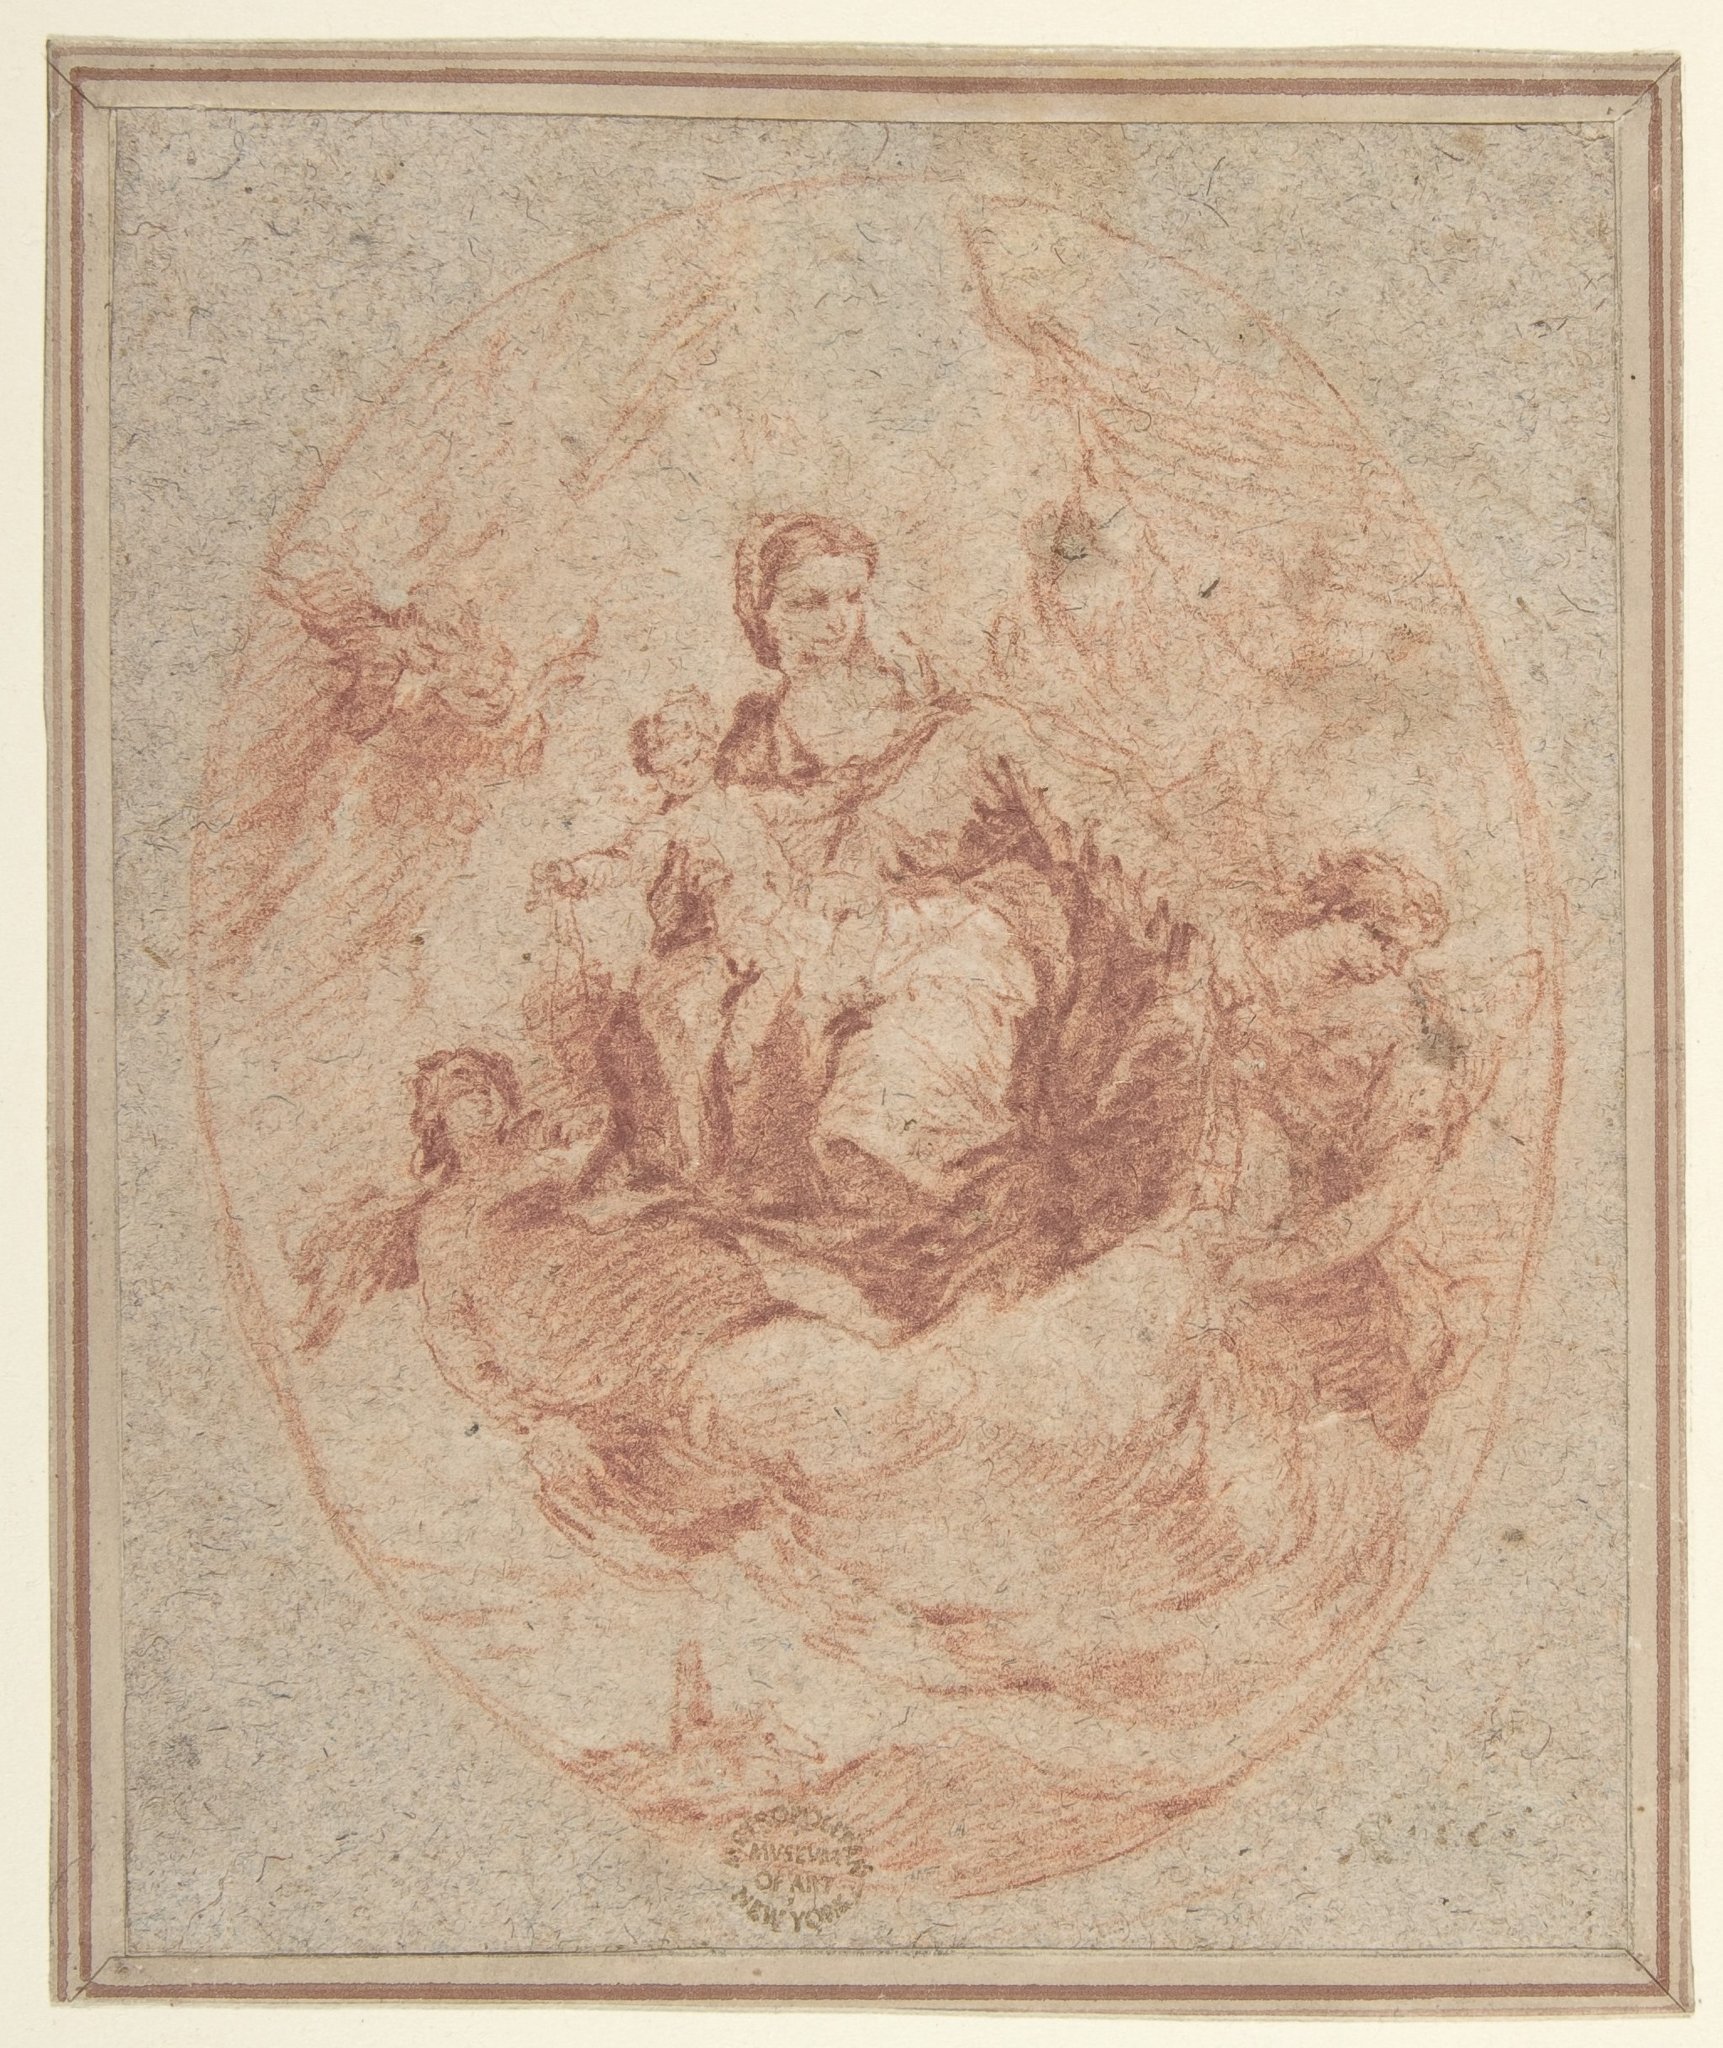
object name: drawing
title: The Virgin and Child Holding Scapulars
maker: francesco guardi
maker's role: artist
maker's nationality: italian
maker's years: 1712-1793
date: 1712-1793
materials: chalk, gouache, paper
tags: angels,madonna and child